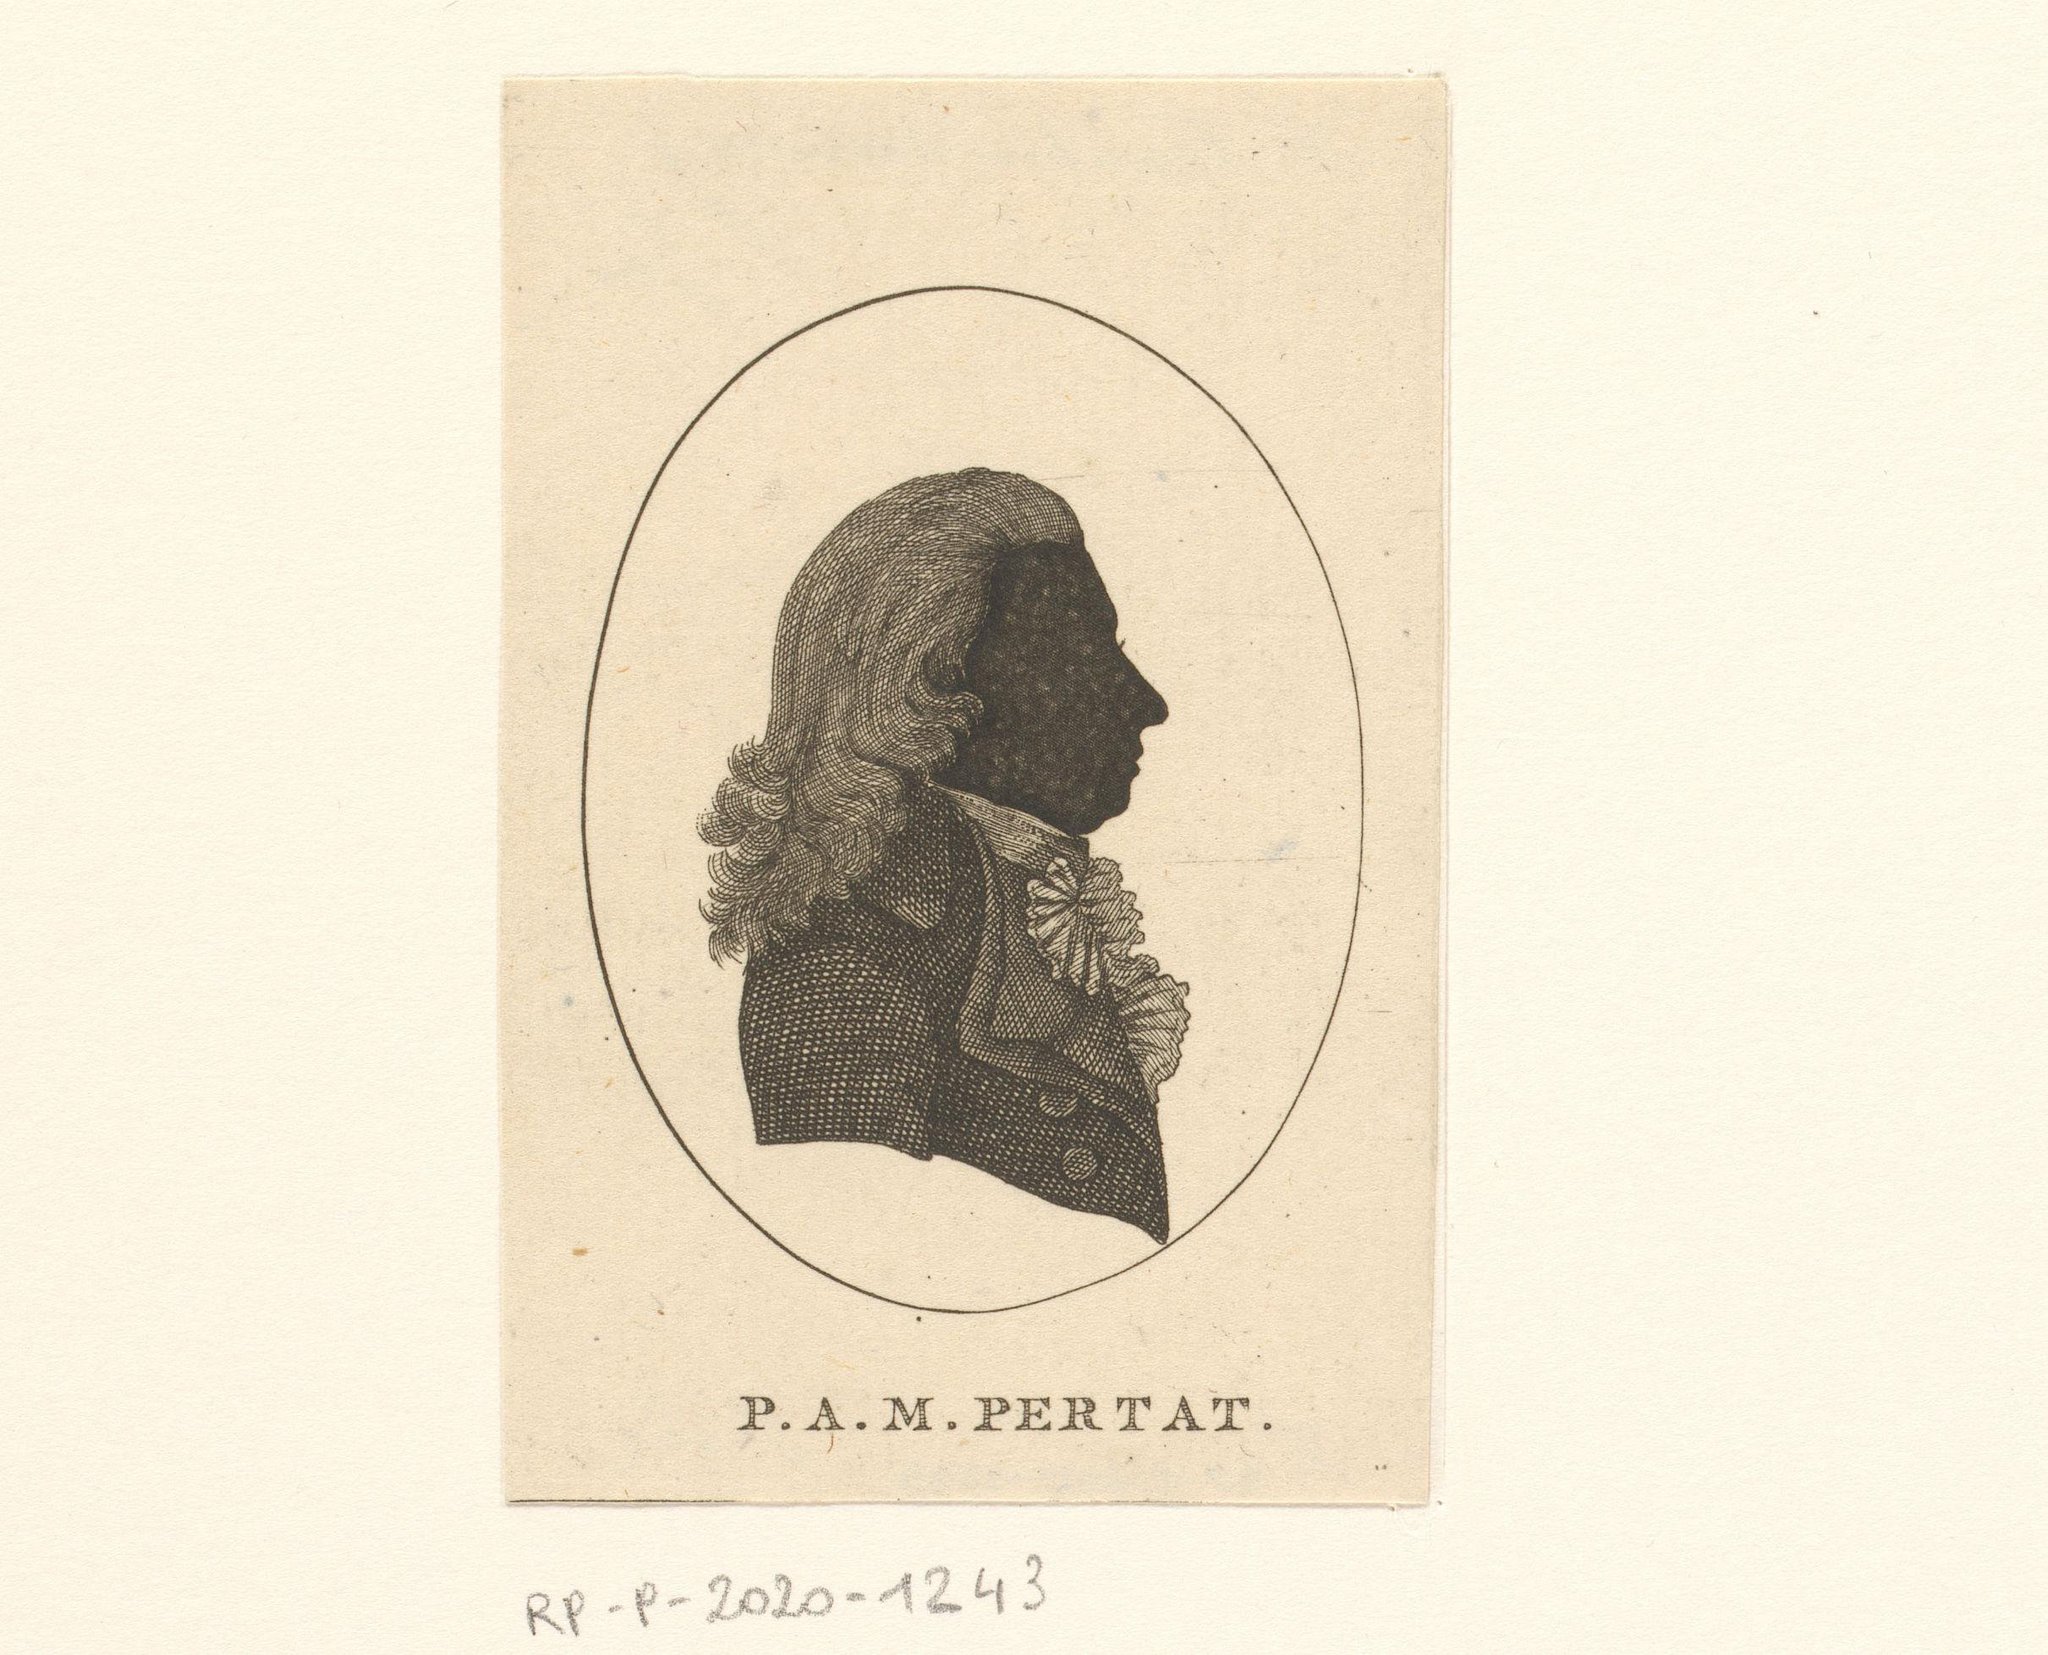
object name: print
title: P.A.M. Pertat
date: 1799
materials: paper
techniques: etching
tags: amsterdam, politician, historical persons, politician, e.g. party leader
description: Prent maakt deel uit van een grotere prent die later is verknipt. Prent gebruikt in: Rogge, Cornelis. Geschiedenis der staatsregeling, voor het Bataafsche volk. Amsterdam: Johannes Allart, 1799.